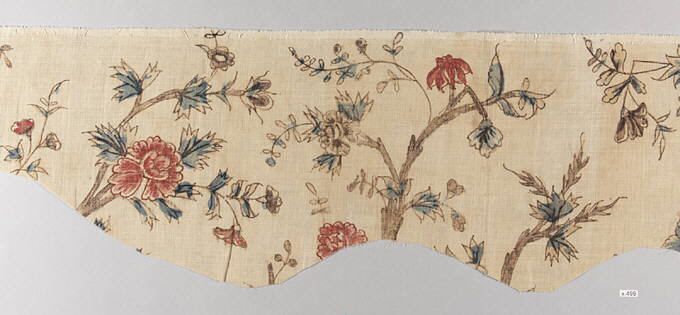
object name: border or valance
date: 1701-1800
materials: cotton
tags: flowers